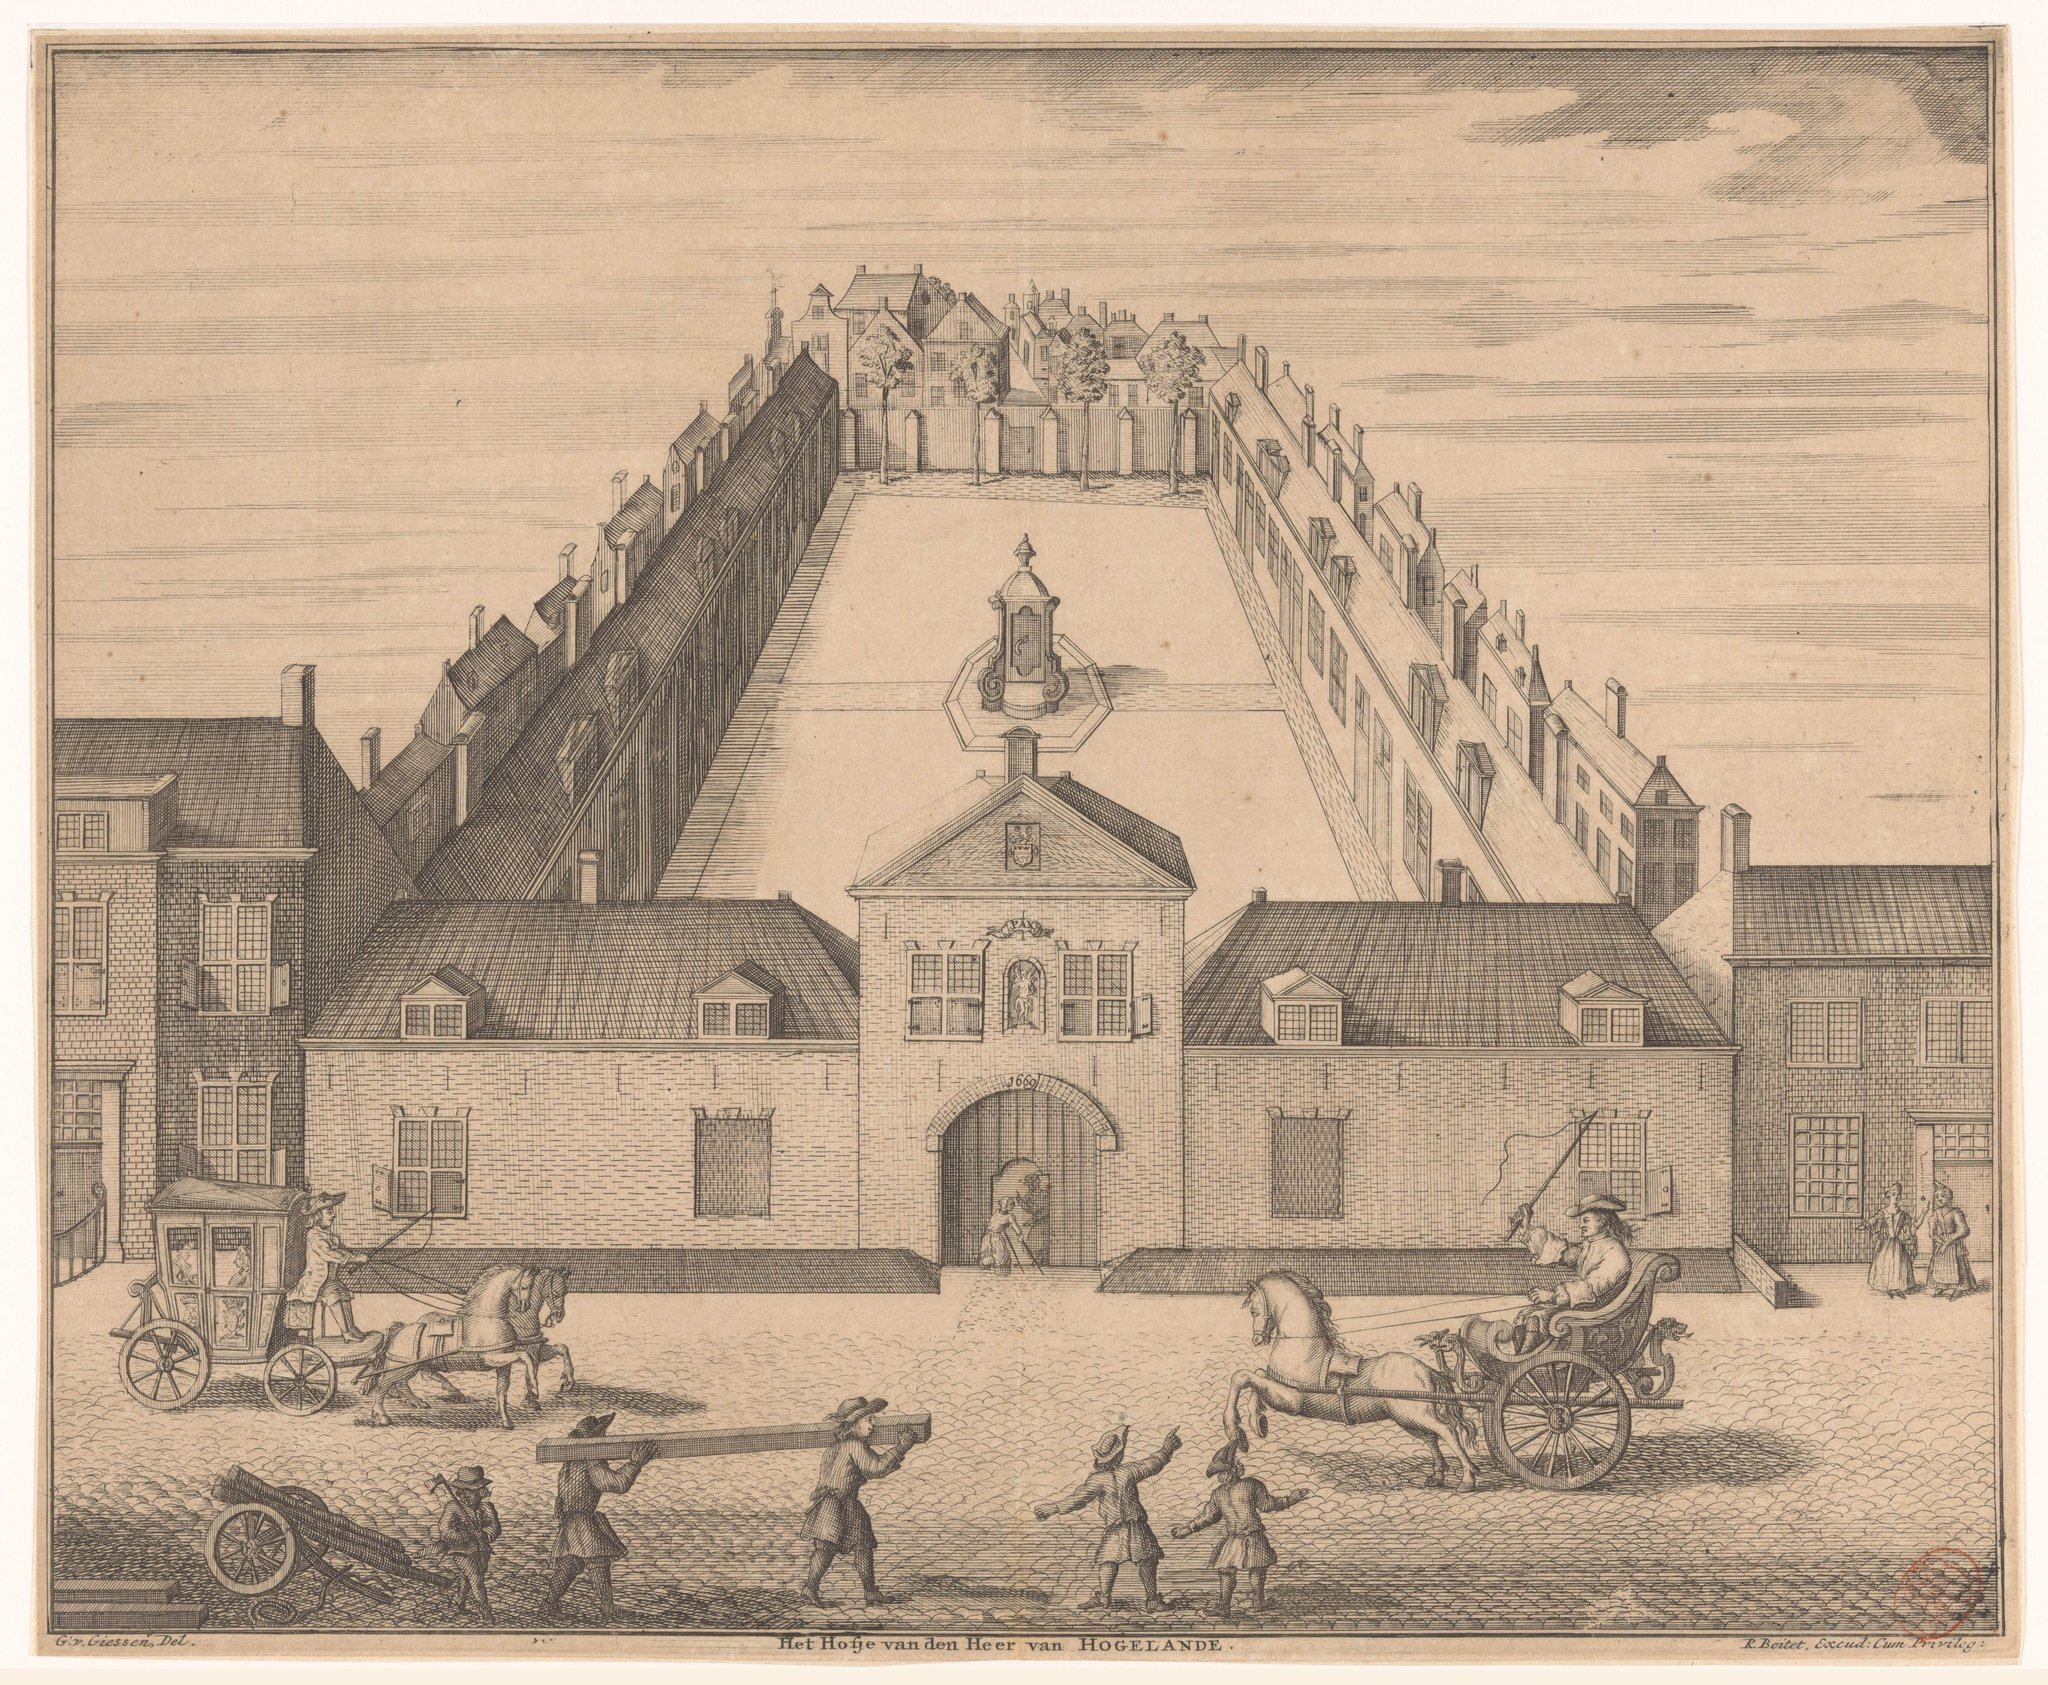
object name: book illustration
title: Gezicht op het Hofje van Hoogelande te Den Haag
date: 1730-1736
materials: paper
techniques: engraving, etching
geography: the hague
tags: alms-house (dutch: 'hofje'), gate, entrance, courtyard, pump, street (+ city(-scape) with figures, staffage)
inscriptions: collector's mark: Lugt 2228, collector's mark: Lugt 195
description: Gezicht op het Hofje van Hoogelande aan de Boekhorststraat te Den Haag. Achter het poortgebouw de binnenplaats met daaromheen de huisjes. In het midden van de binnenplaats een waterpomp. Op straat verschillende figuren.